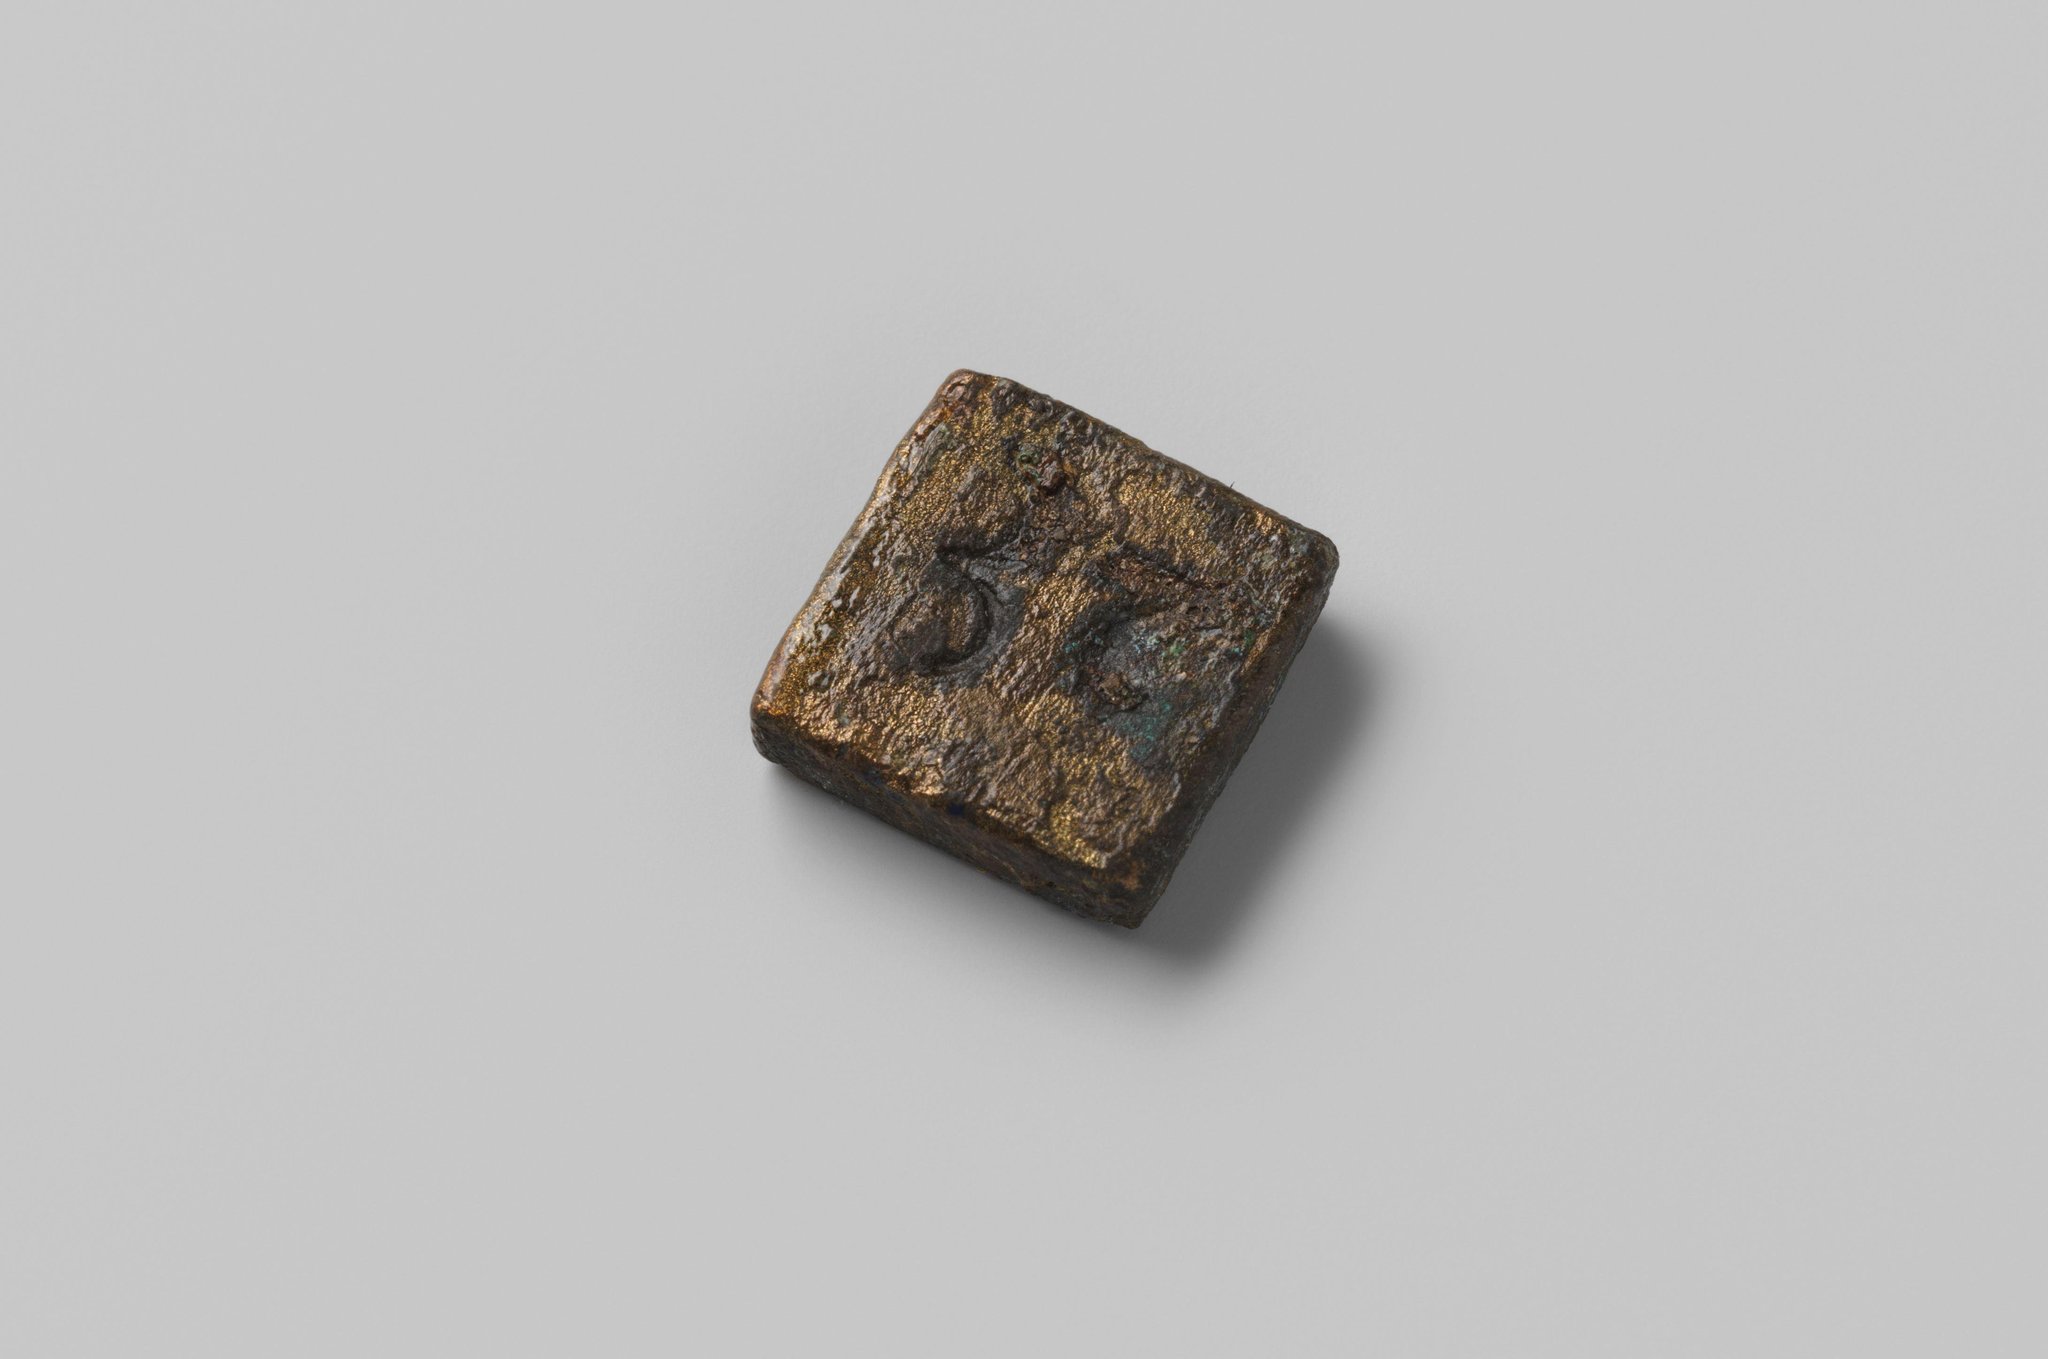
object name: weight scale component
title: Gewicht van apothekersbalans uit het wrak van de Oost-Indiëvaarder Hollandia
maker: Anonymous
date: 1700-1743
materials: copper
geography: netherlands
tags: verenigde oostindische compagnie, hollandia (schip), annet